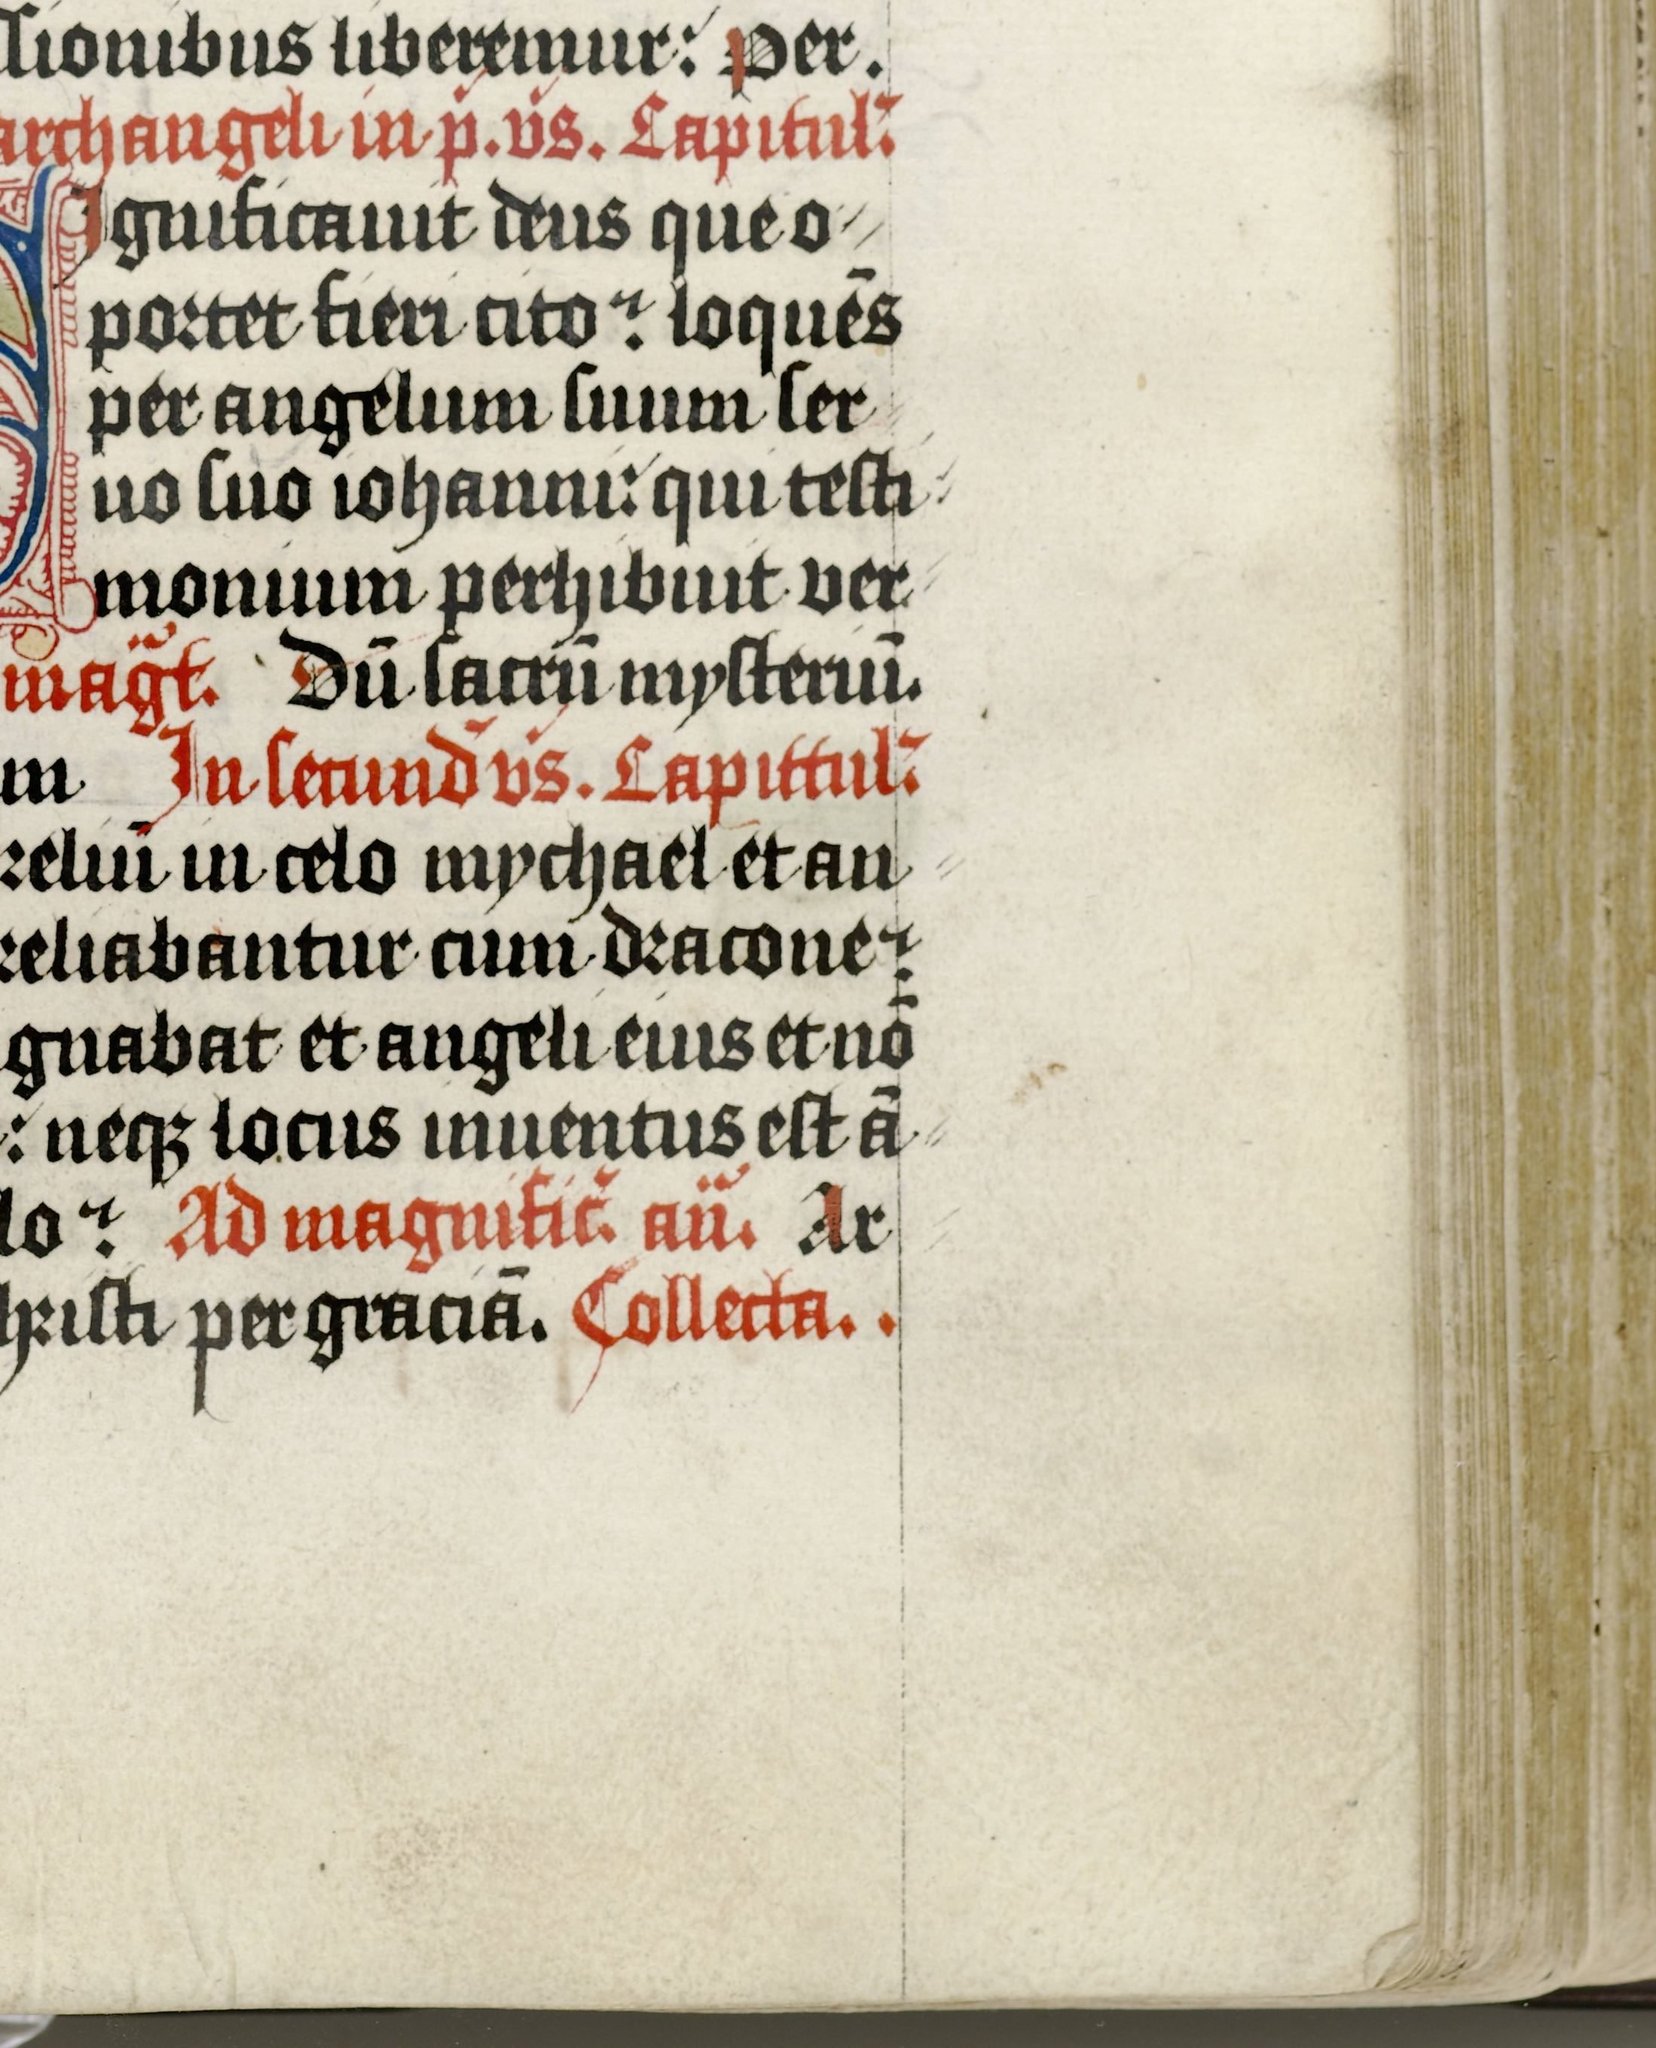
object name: book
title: Psalter en brevier (gedeeltes) in het Latijn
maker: Anonymous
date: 1500-1600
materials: paint, paper, parchment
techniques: pen in colors, brush in colors